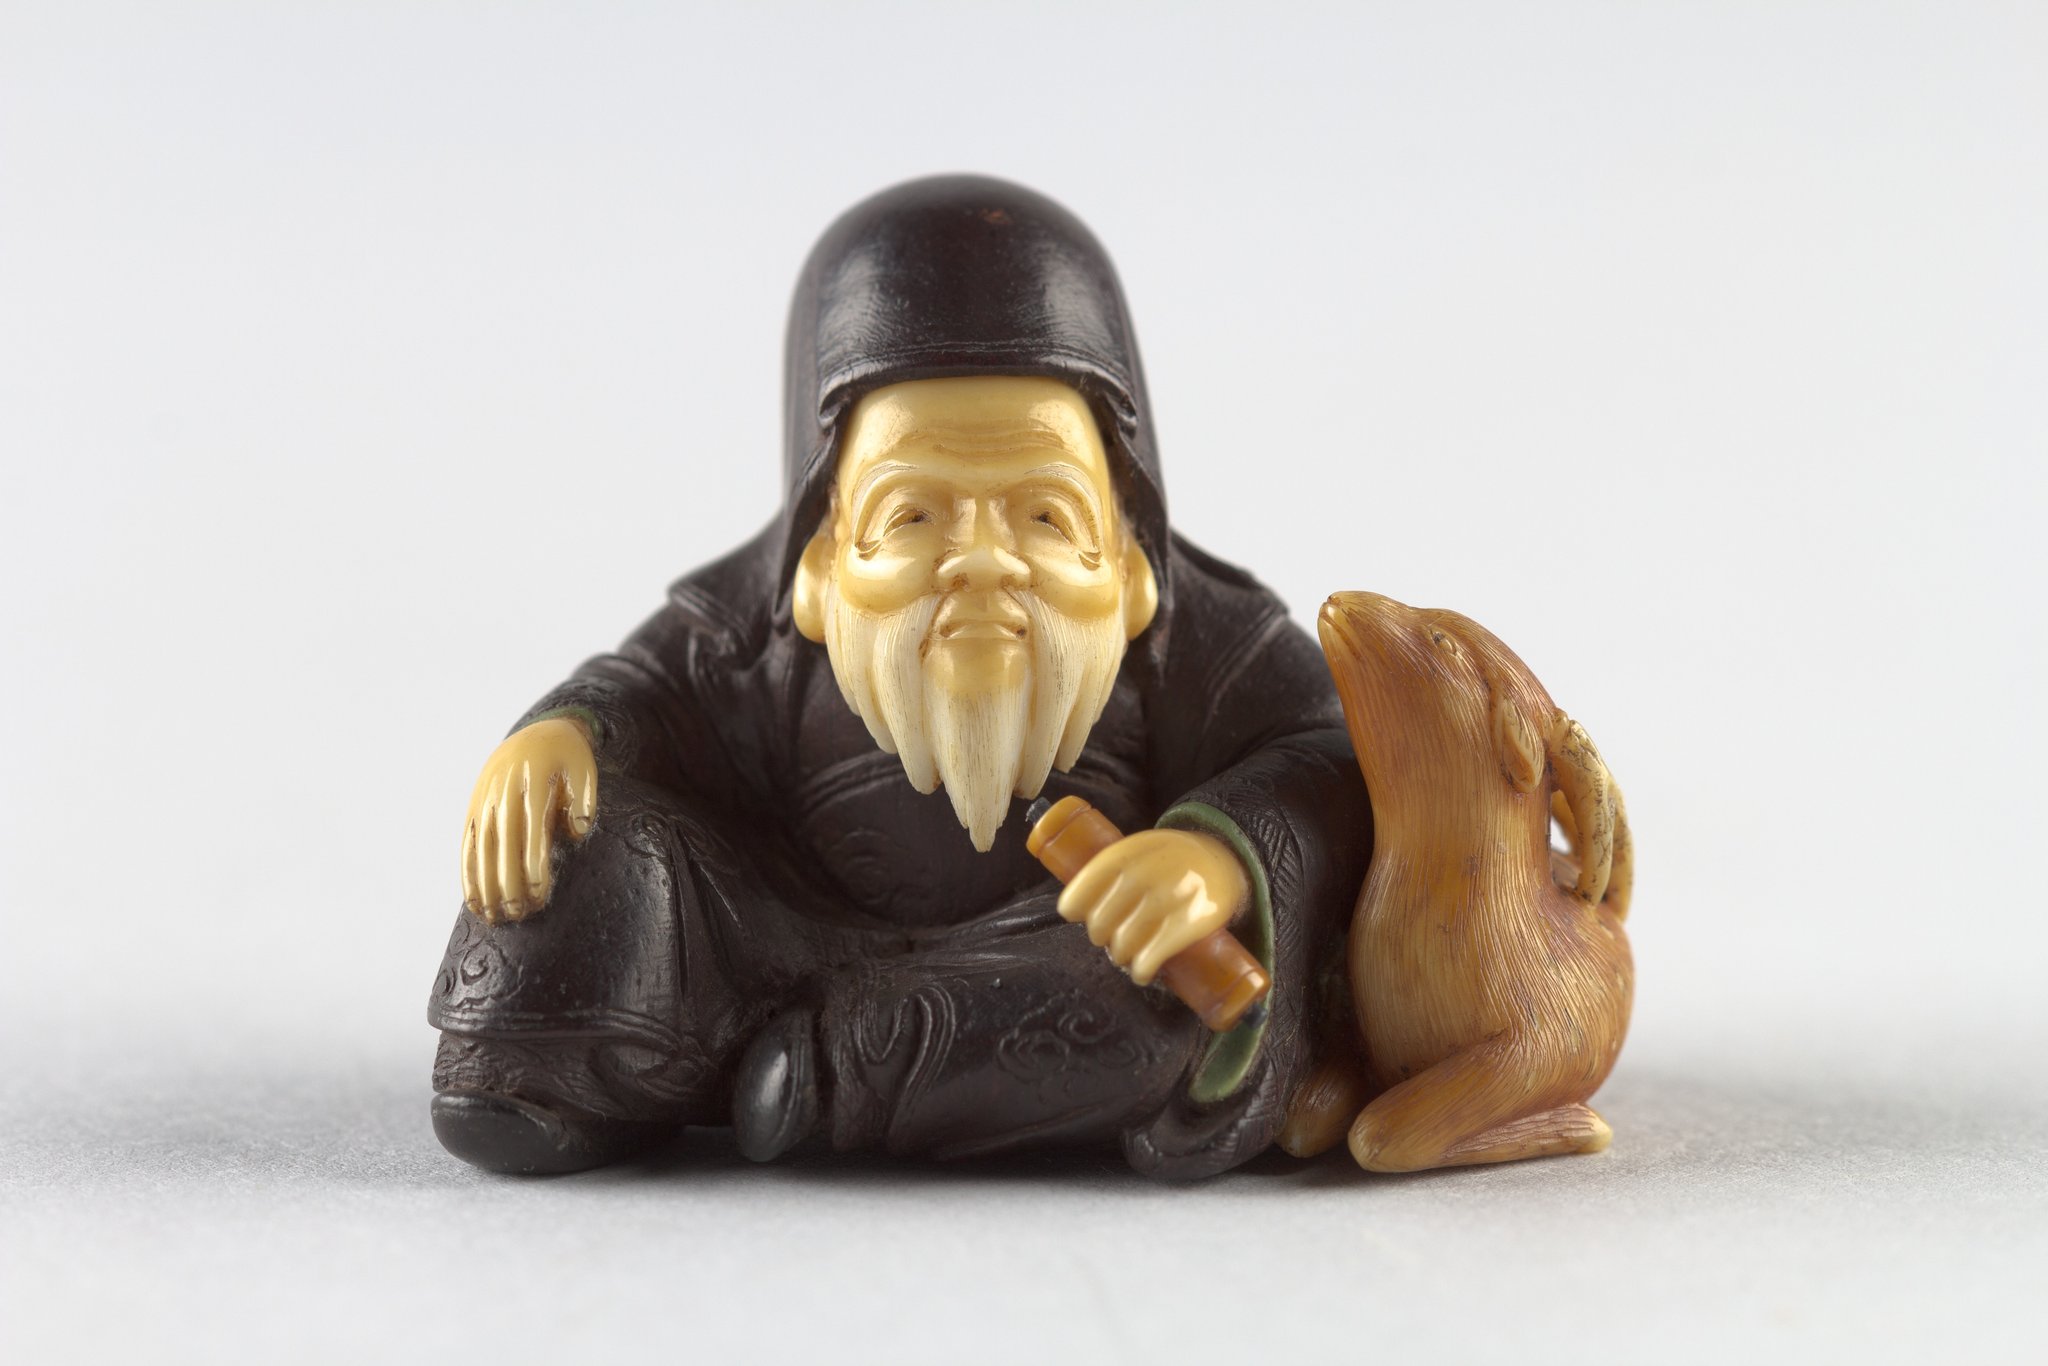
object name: netsuke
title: Netsuke of Fukurokujin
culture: japanese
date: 1801-1900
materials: ivory, wood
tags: men,deer